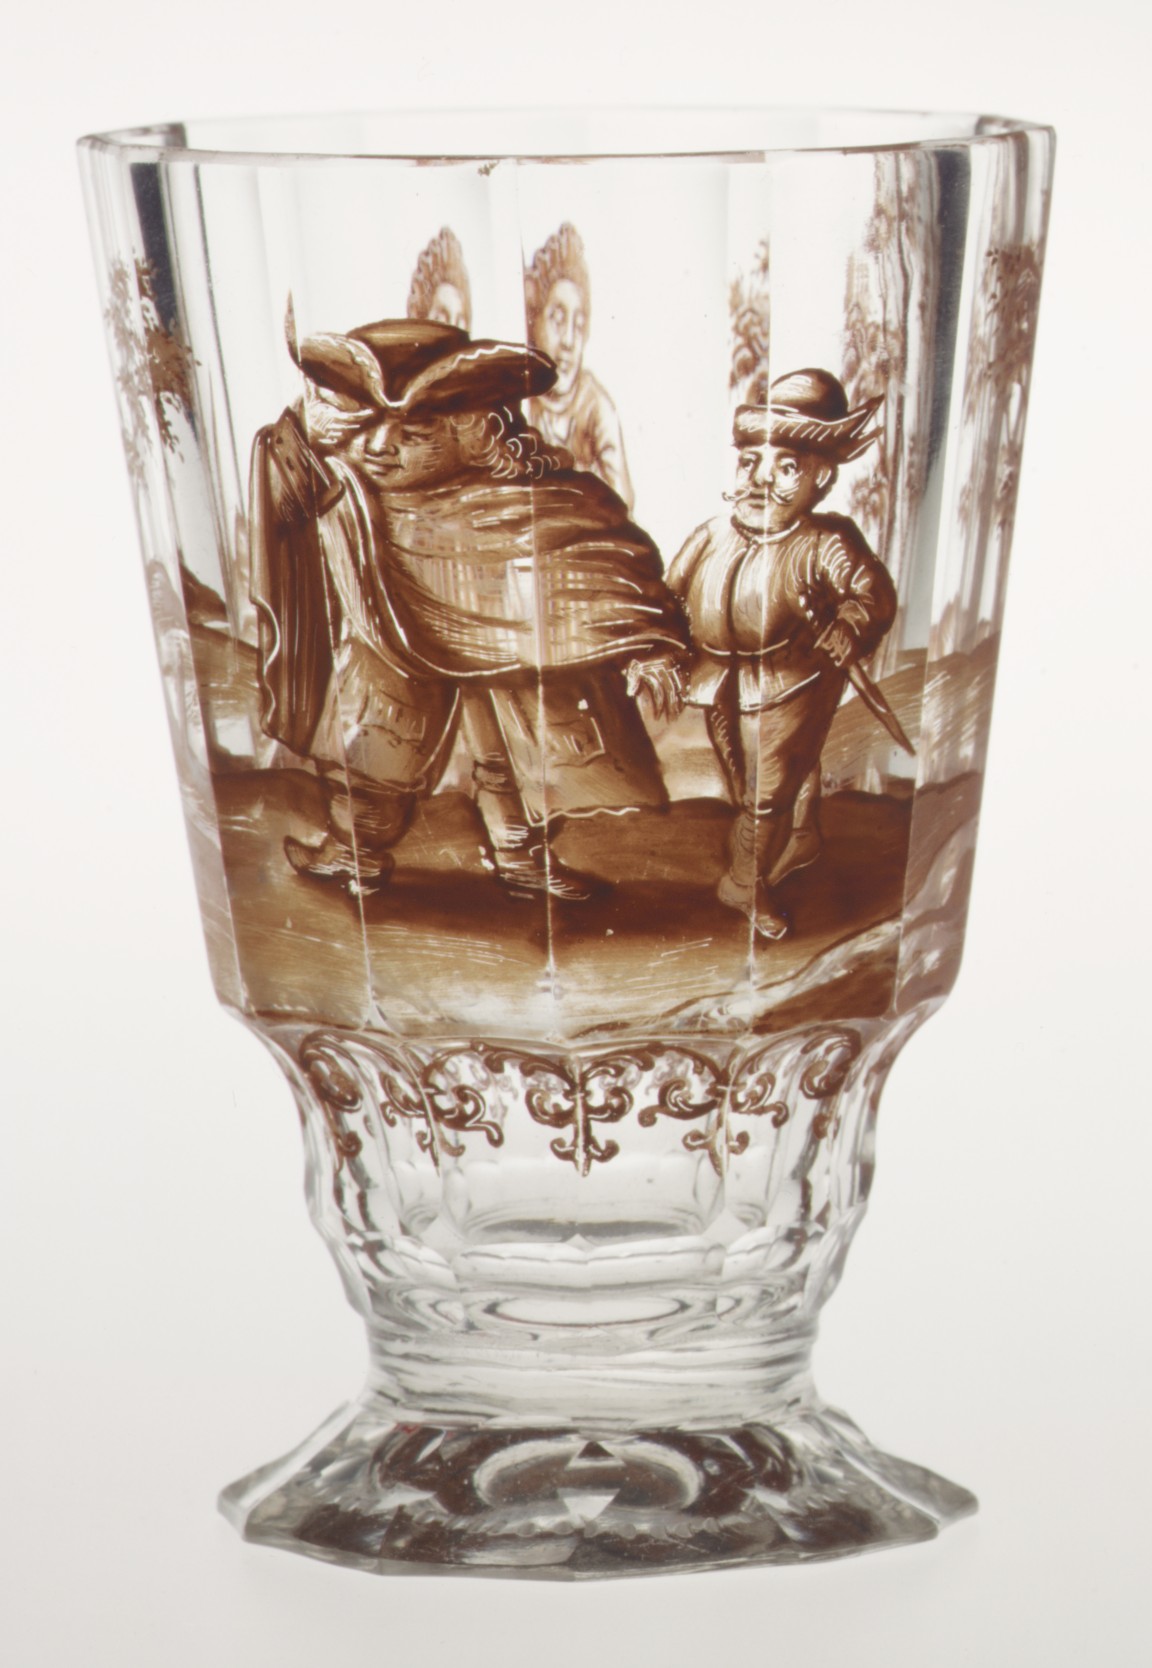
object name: beaker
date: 1720-1730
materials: glass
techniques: painting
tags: men